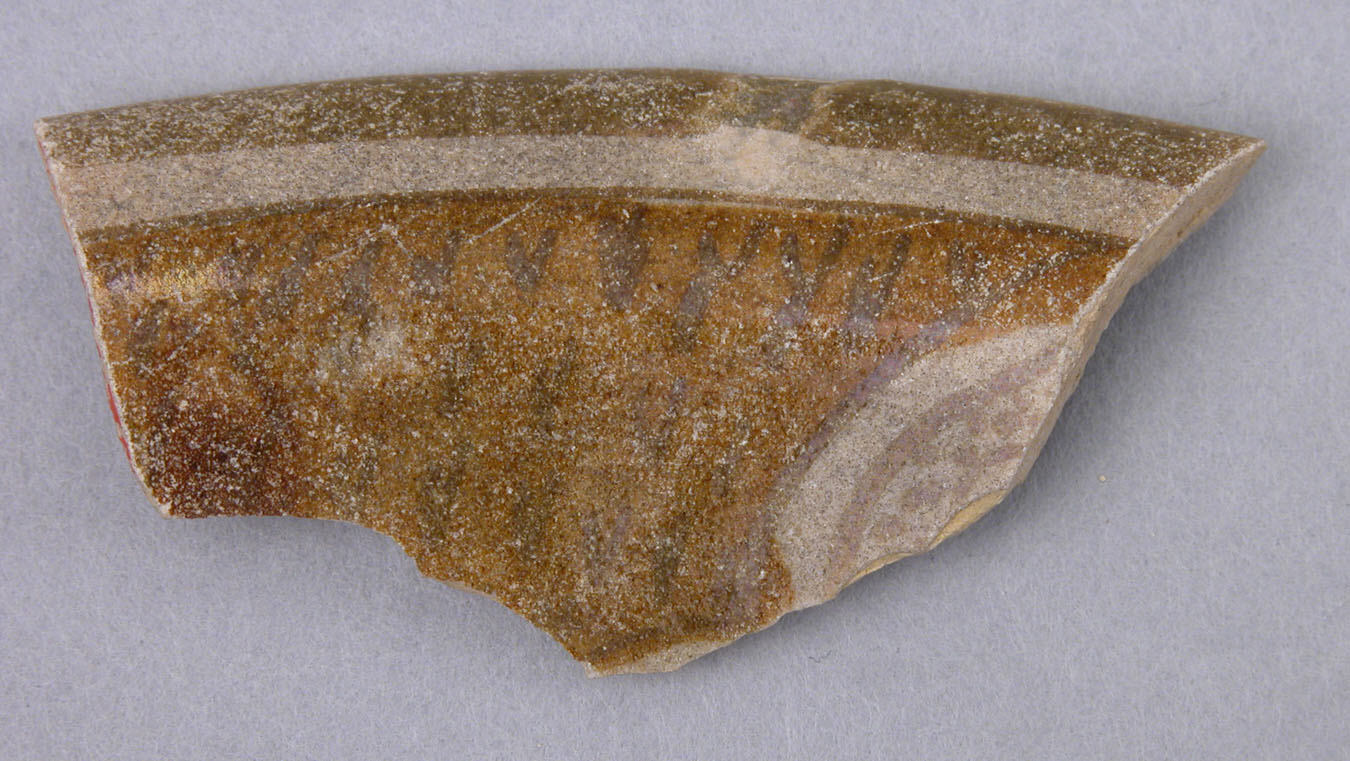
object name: fragment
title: Ceramic Fragment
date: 701-900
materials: earthenware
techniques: glazing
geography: iraq